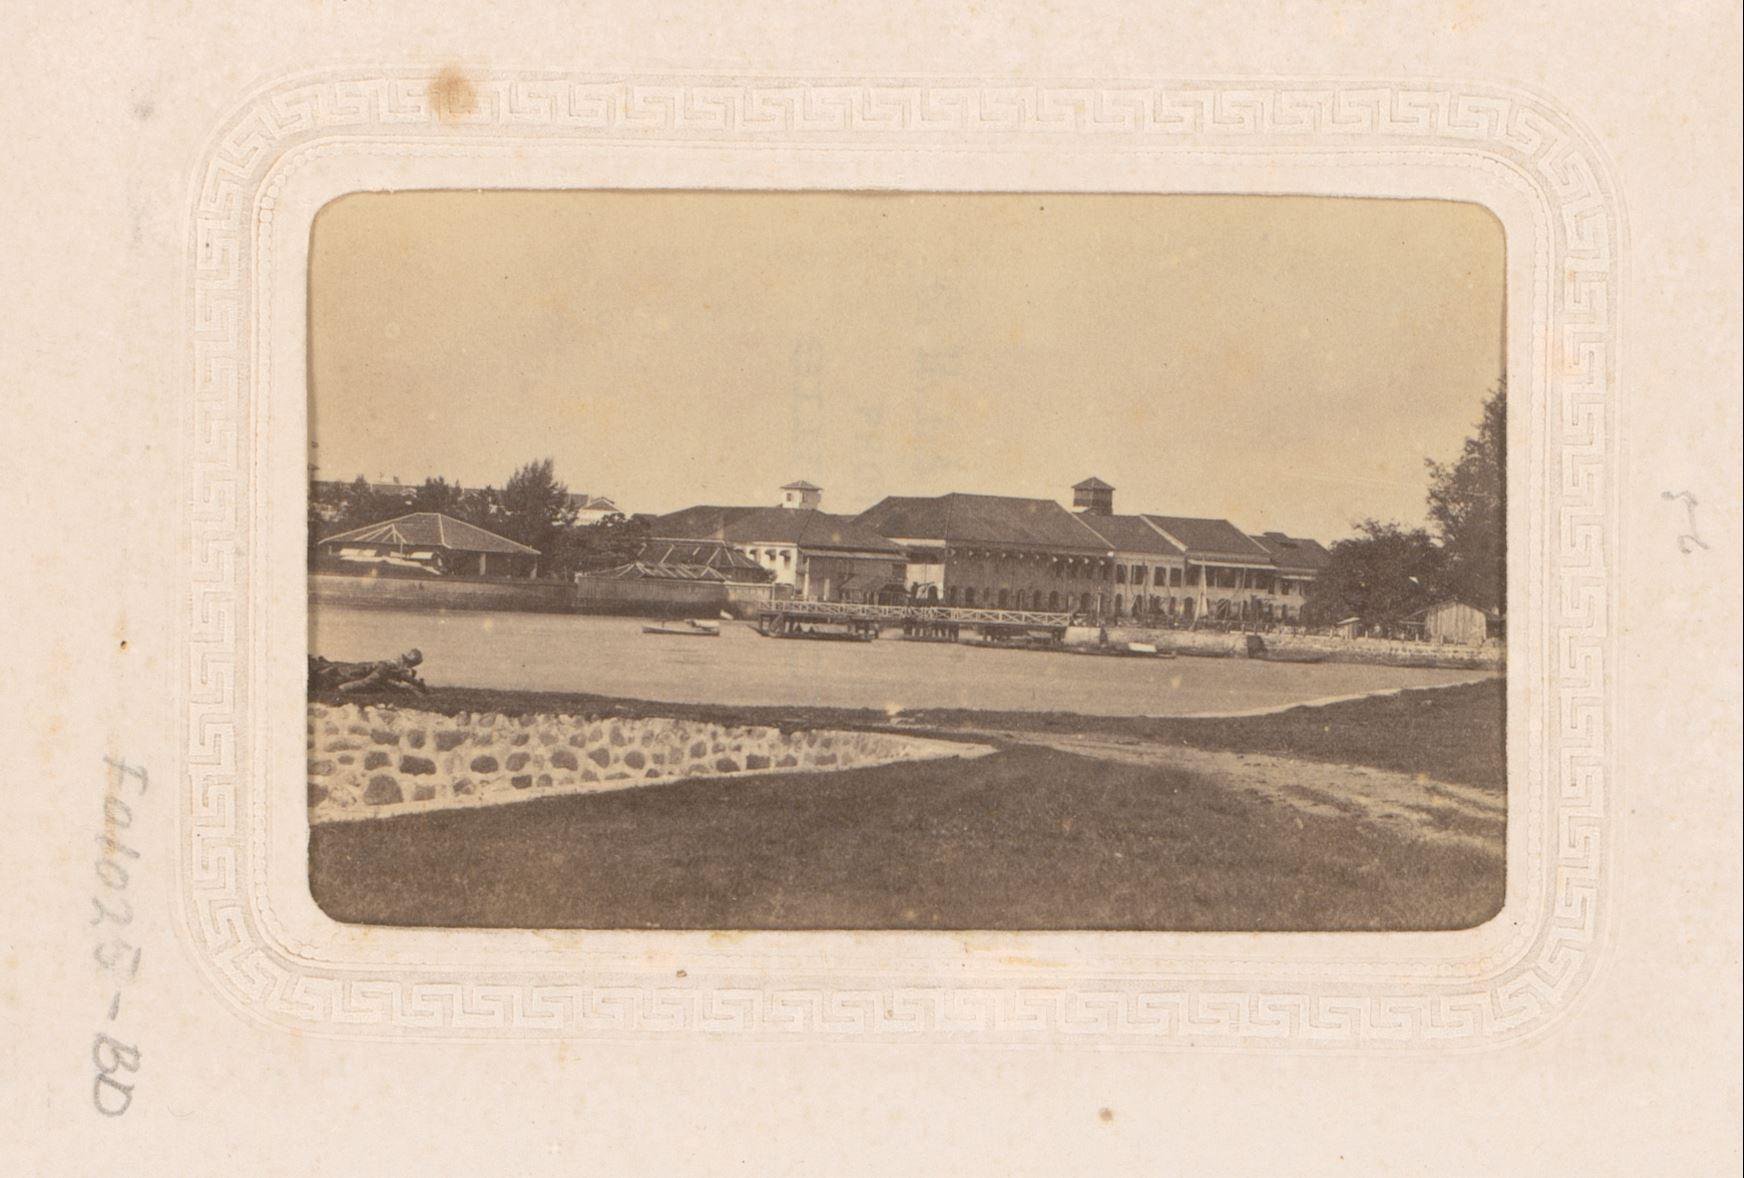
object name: album leaf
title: Gezicht op de haven van Singapore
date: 1867-1880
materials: cardboard, photographic support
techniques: albumen print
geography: singapore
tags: harbour, singapore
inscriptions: number: ‘56’